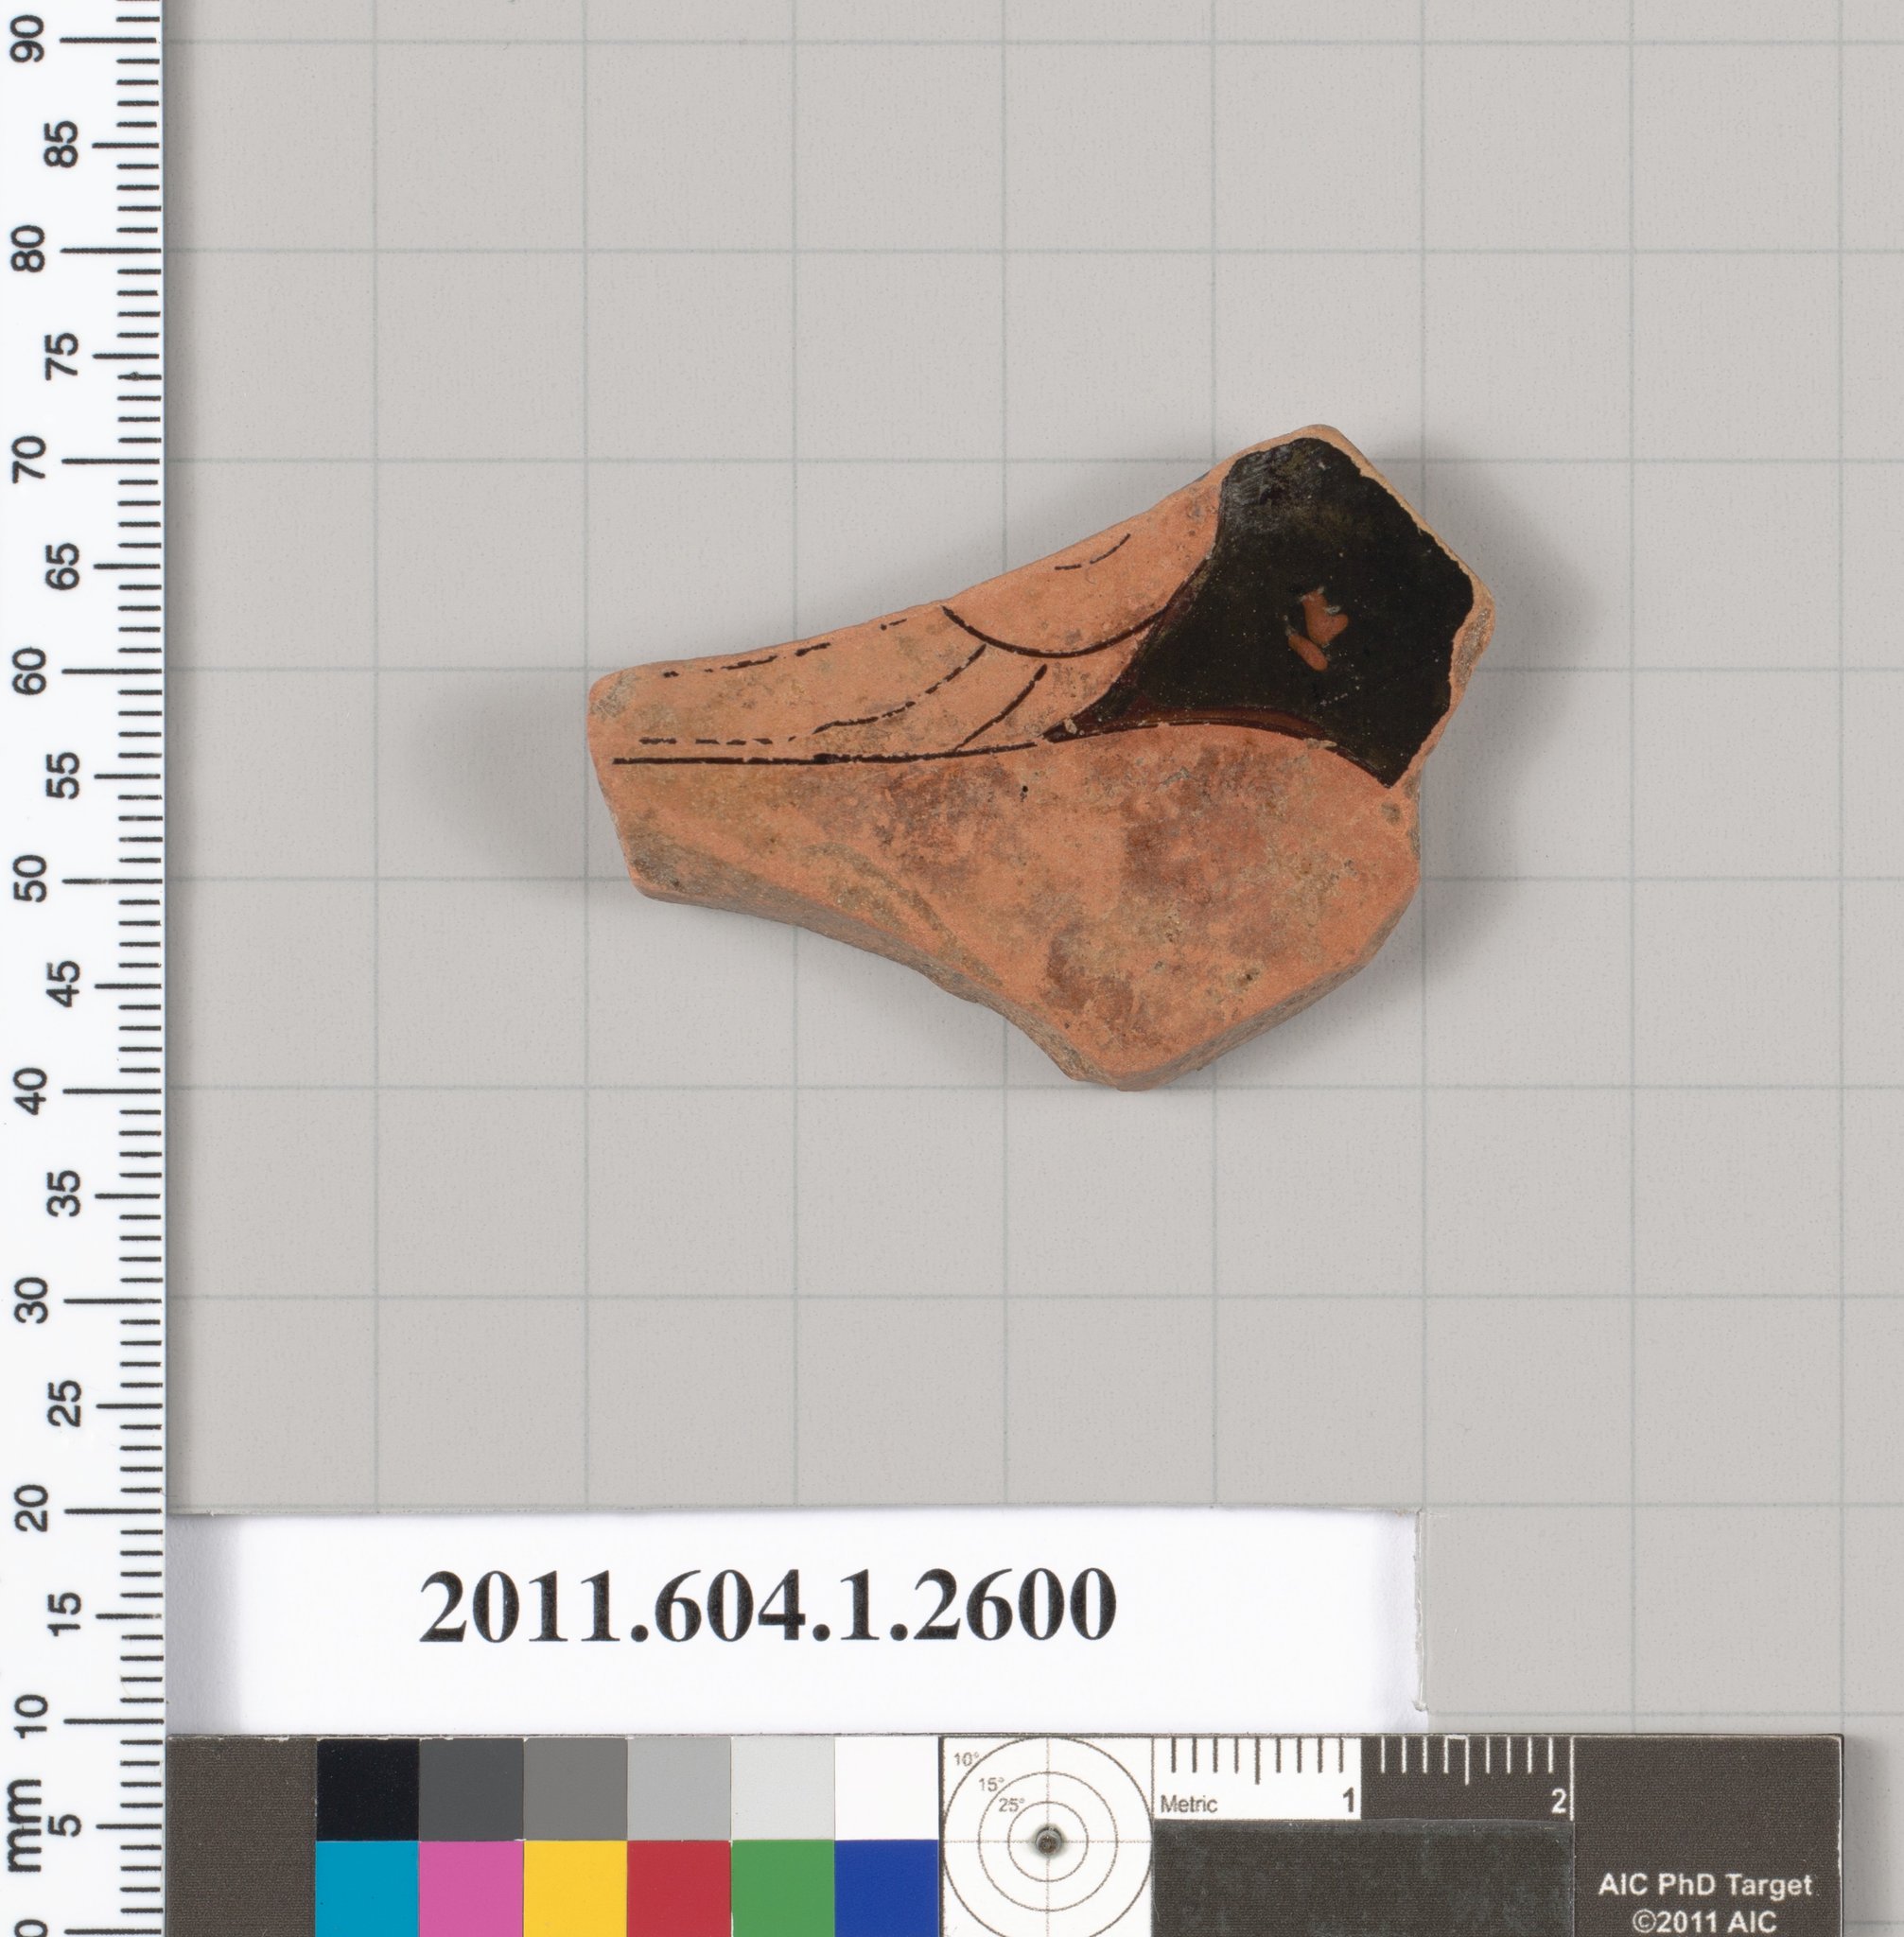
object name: kylix fragment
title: Terracotta fragment of a kylix (drinking cup)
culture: greek, attic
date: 500-451 BCE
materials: terracotta